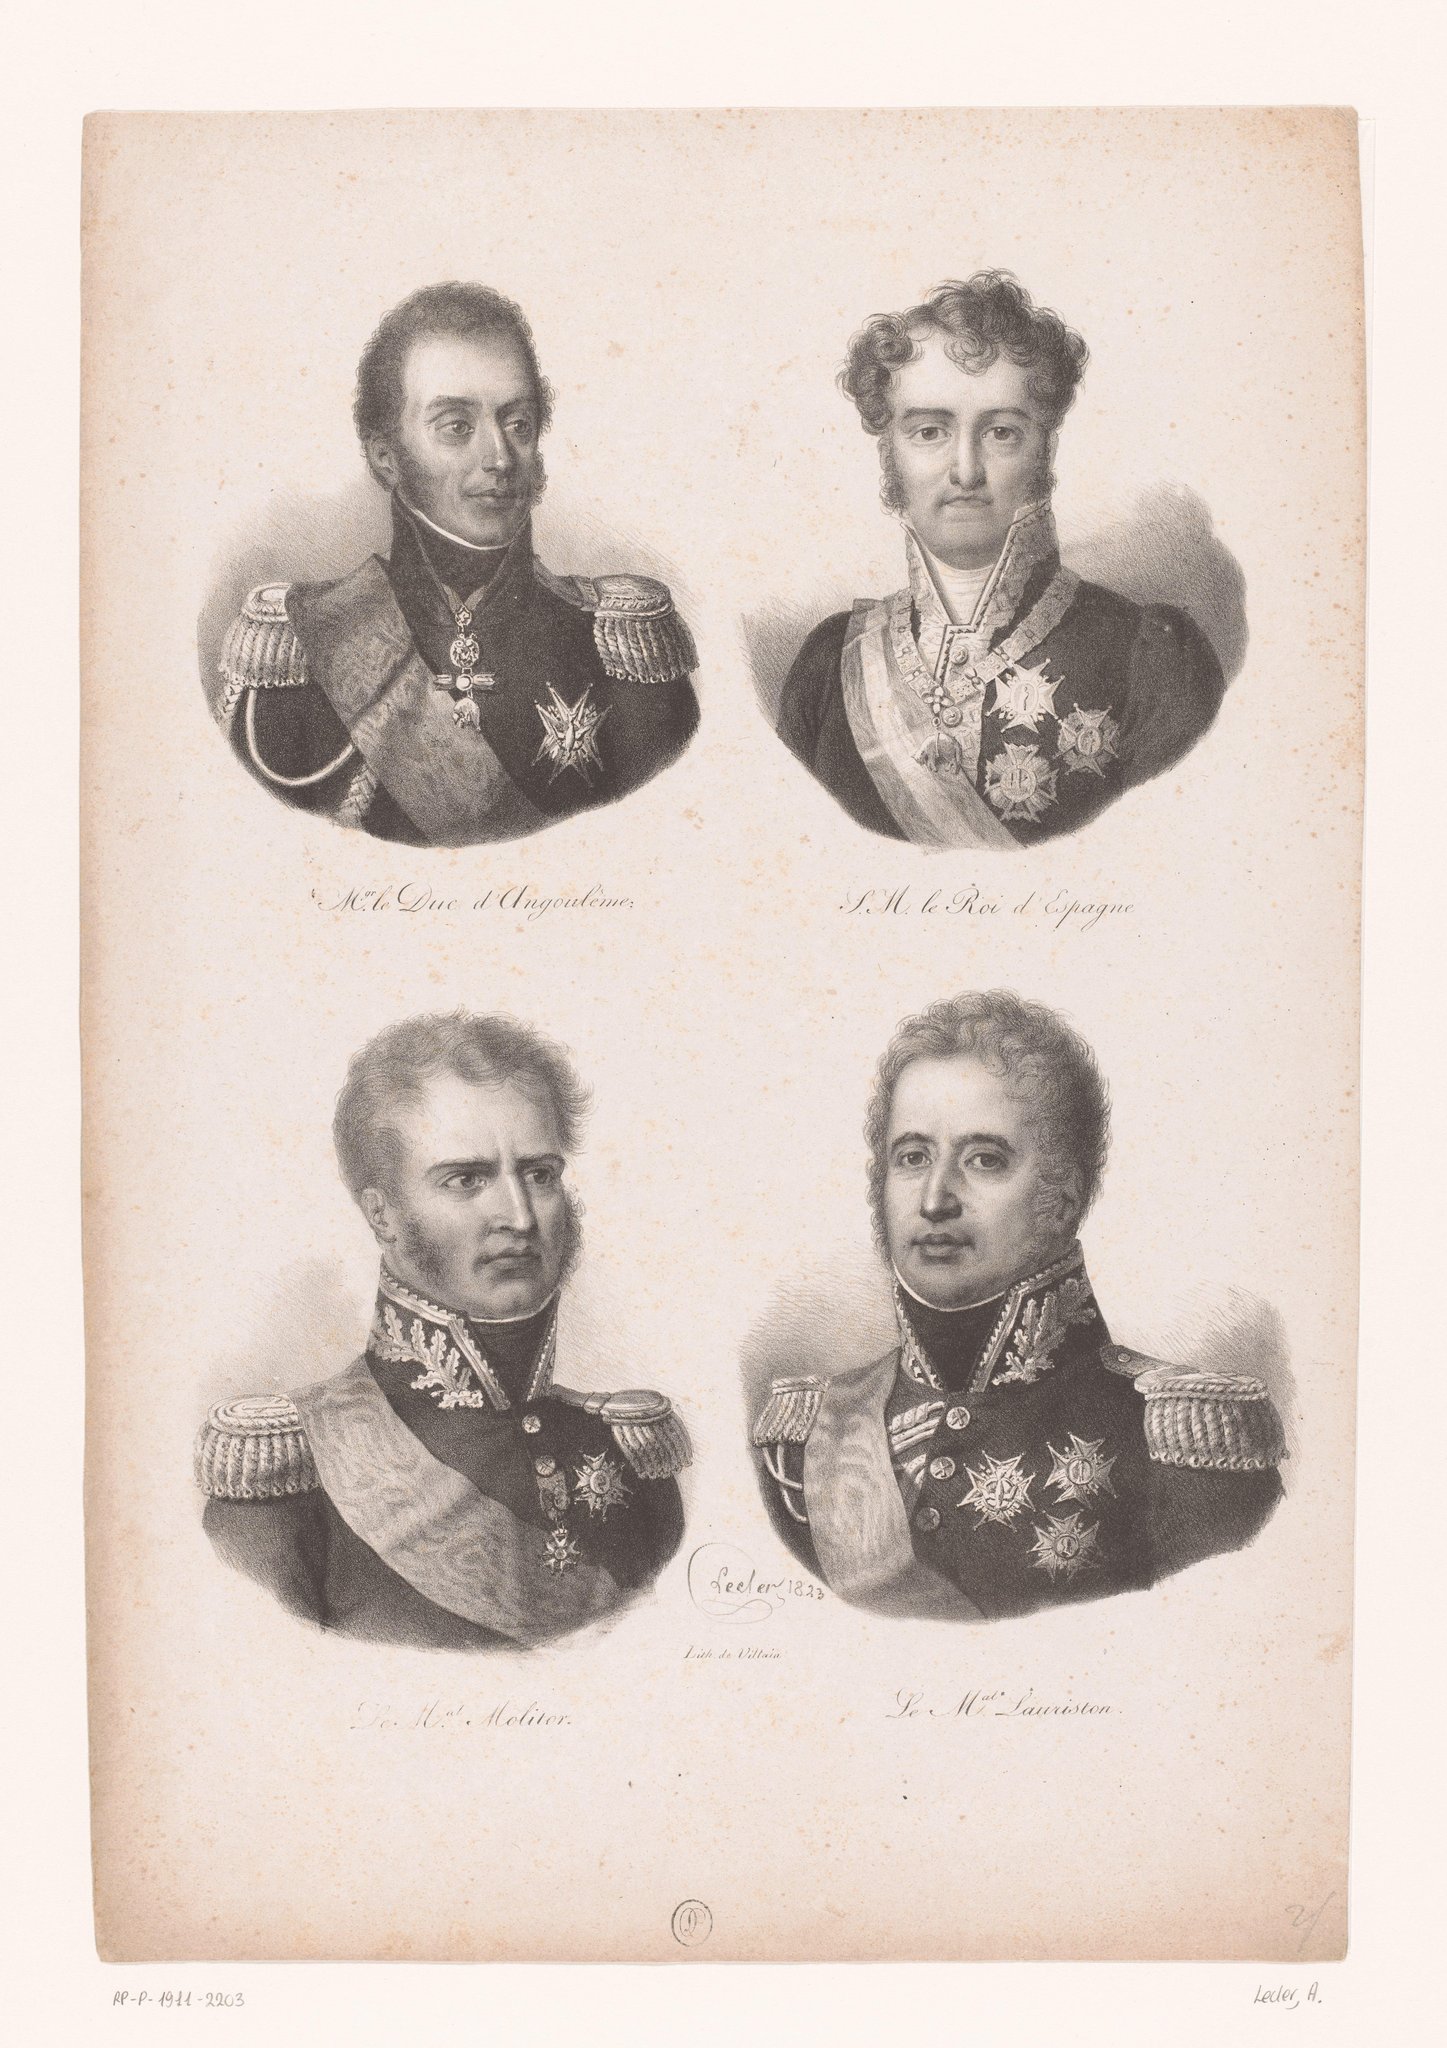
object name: print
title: Portretten van vier hoge Franse legerleiders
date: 1823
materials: paper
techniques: lithograph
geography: paris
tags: paris, politician, ferdinand vii (koning van spanje), commander-in-chief, general, marshal, historical persons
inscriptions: stamp: Lugt 4724, collector's mark: Lugt 2228a